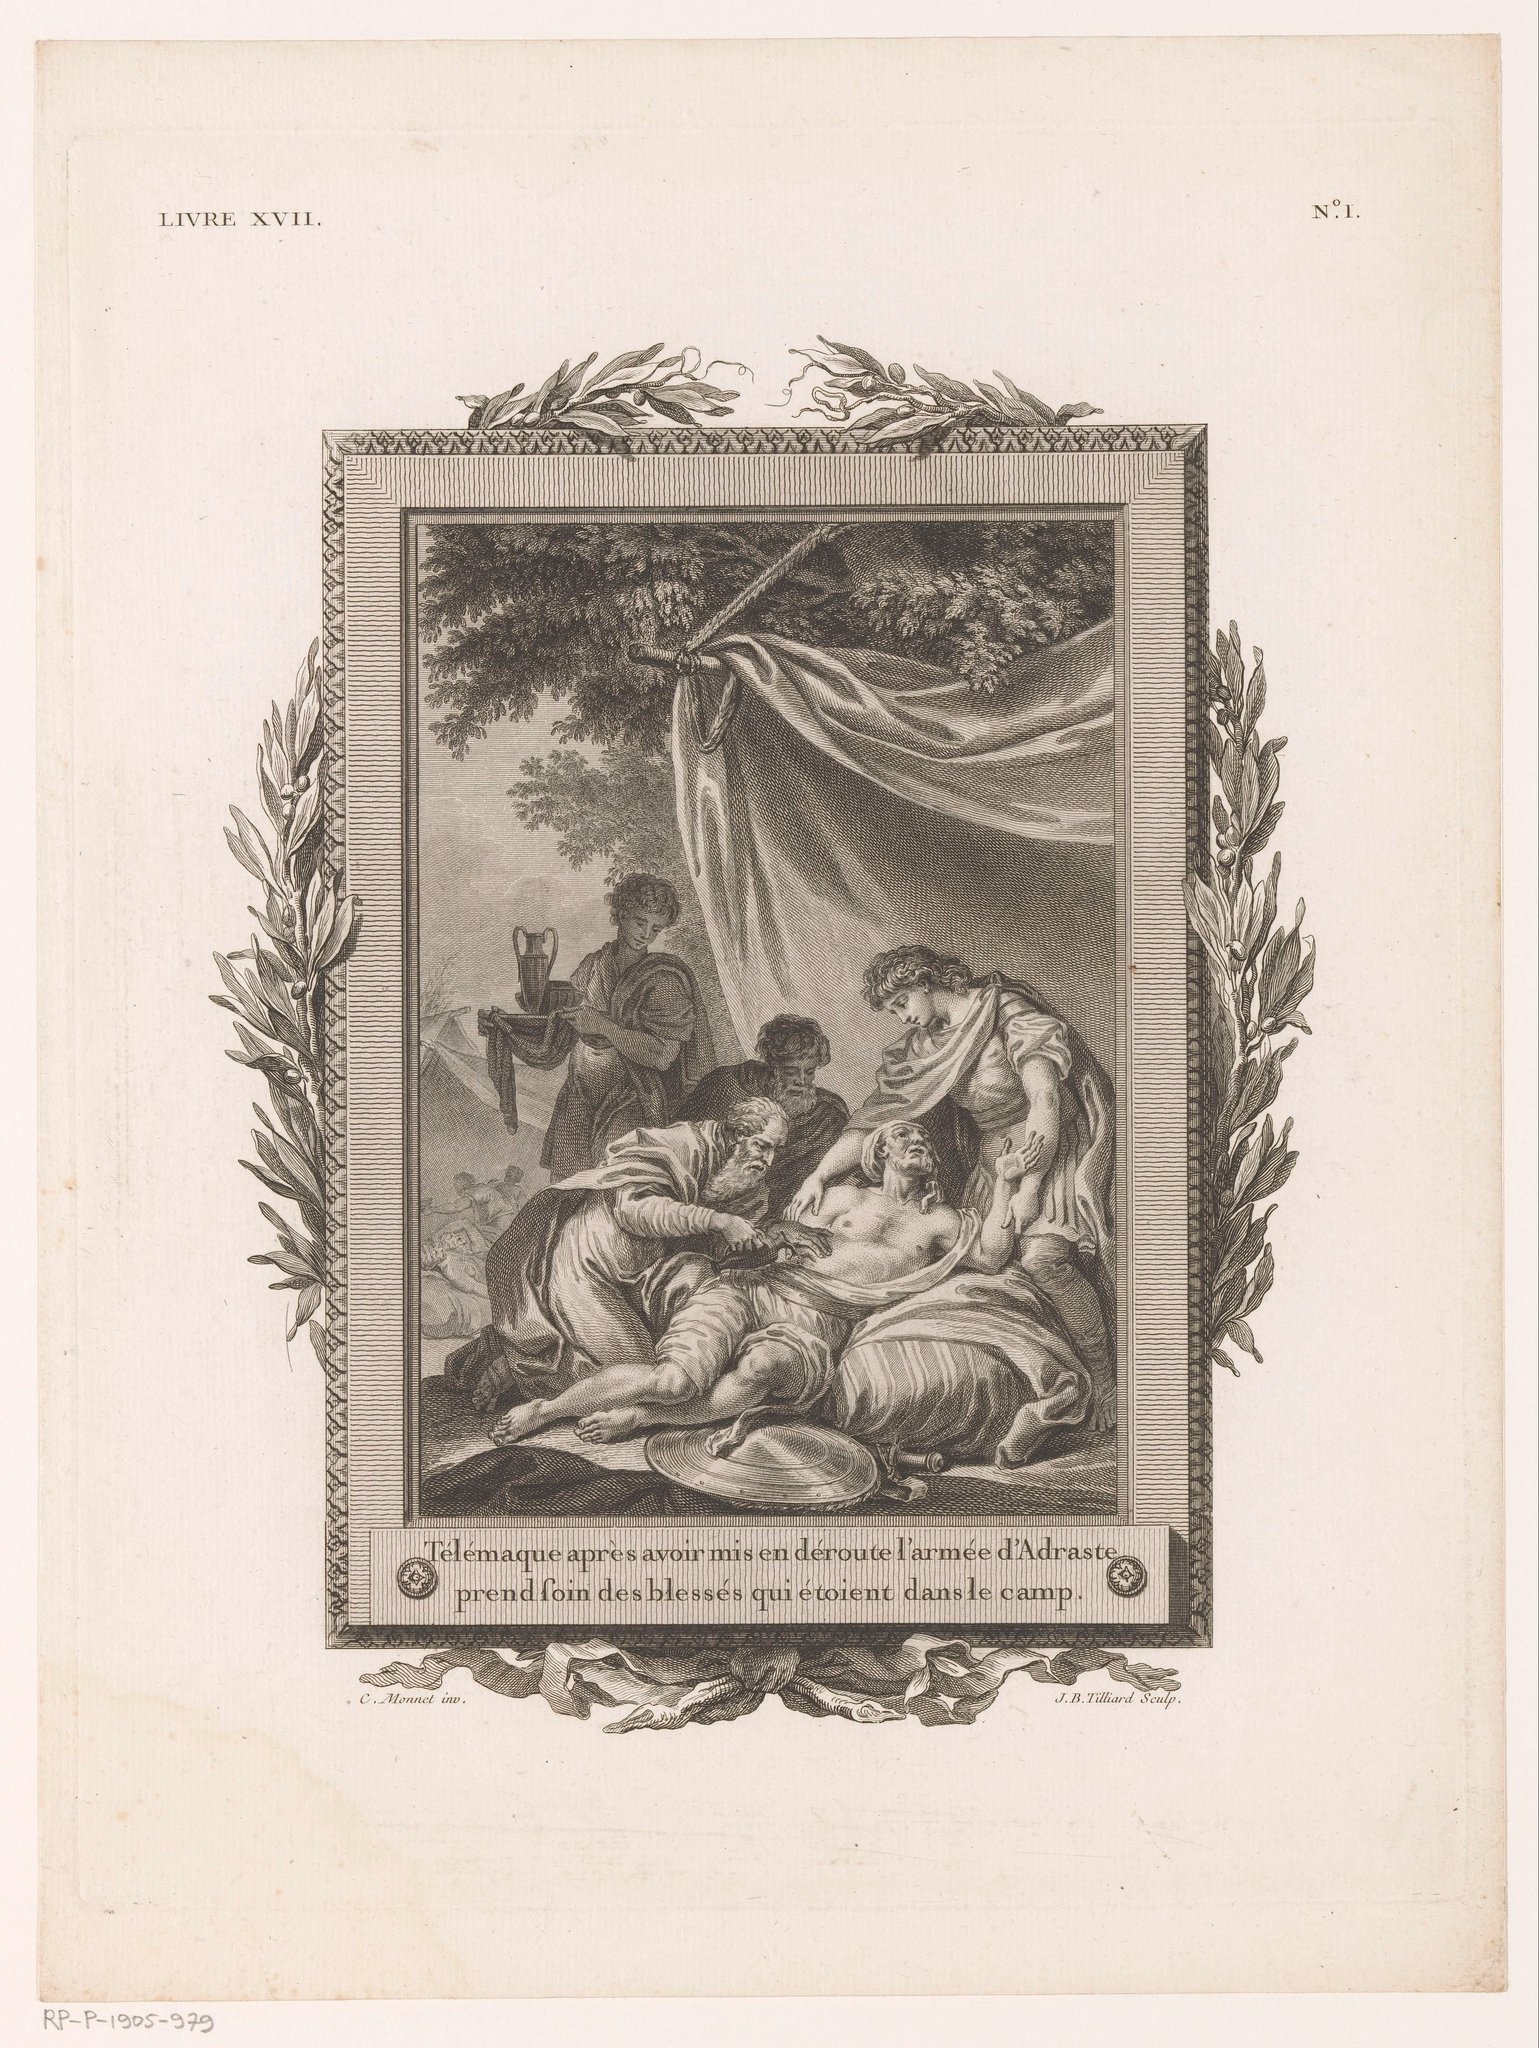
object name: book illustration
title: Telemachus zorgt voor de gewonden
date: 1785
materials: paper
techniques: engraving, etching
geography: paris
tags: (fenelon, telemachus) specific works of literature (with author, title), (story of) telemachus, ornament ~ festoon, garland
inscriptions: collector's mark: Lugt 2228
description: Een gewonde soldaat, liggend op een kussen onder een baldakijn, wordt bezocht door Telemachus, staand achter hem. Het geheel wordt gekaderd door een sierlijst met olijftakken en onderaan een strik. Genummerd rechtsboven: No. I.